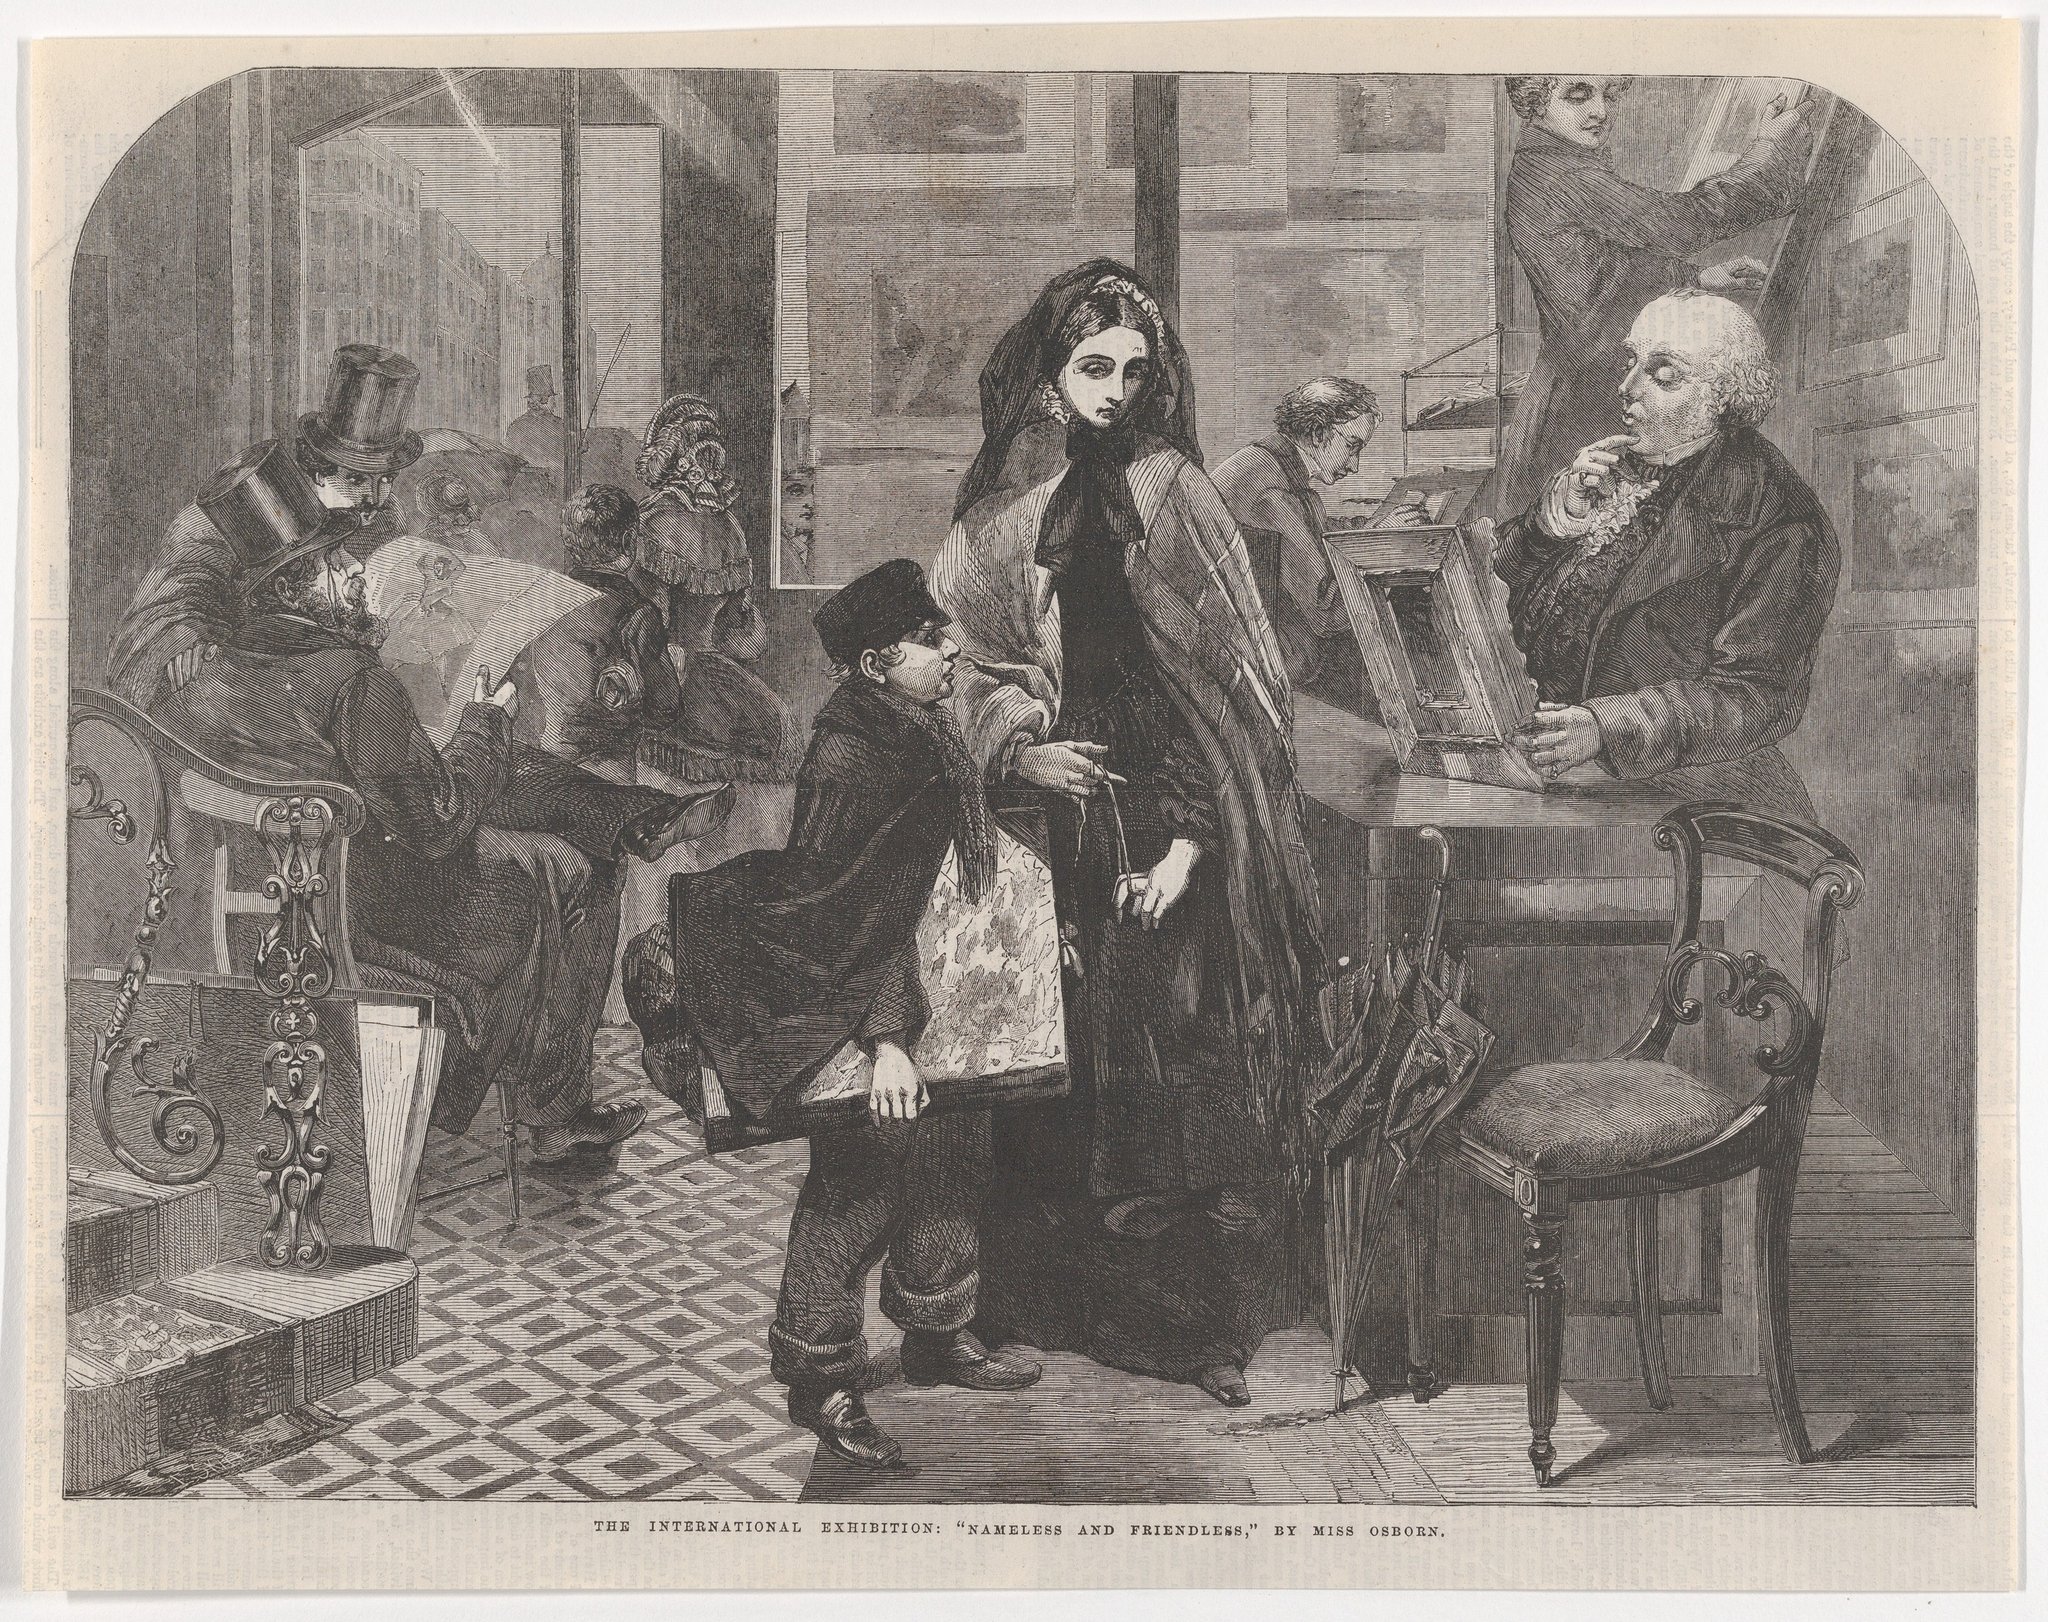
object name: print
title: Nameless and Friendless, from "Illustrated London News"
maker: emily mary osborn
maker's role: artist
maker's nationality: british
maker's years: 1828-1925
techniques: engraving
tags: boys,men,women